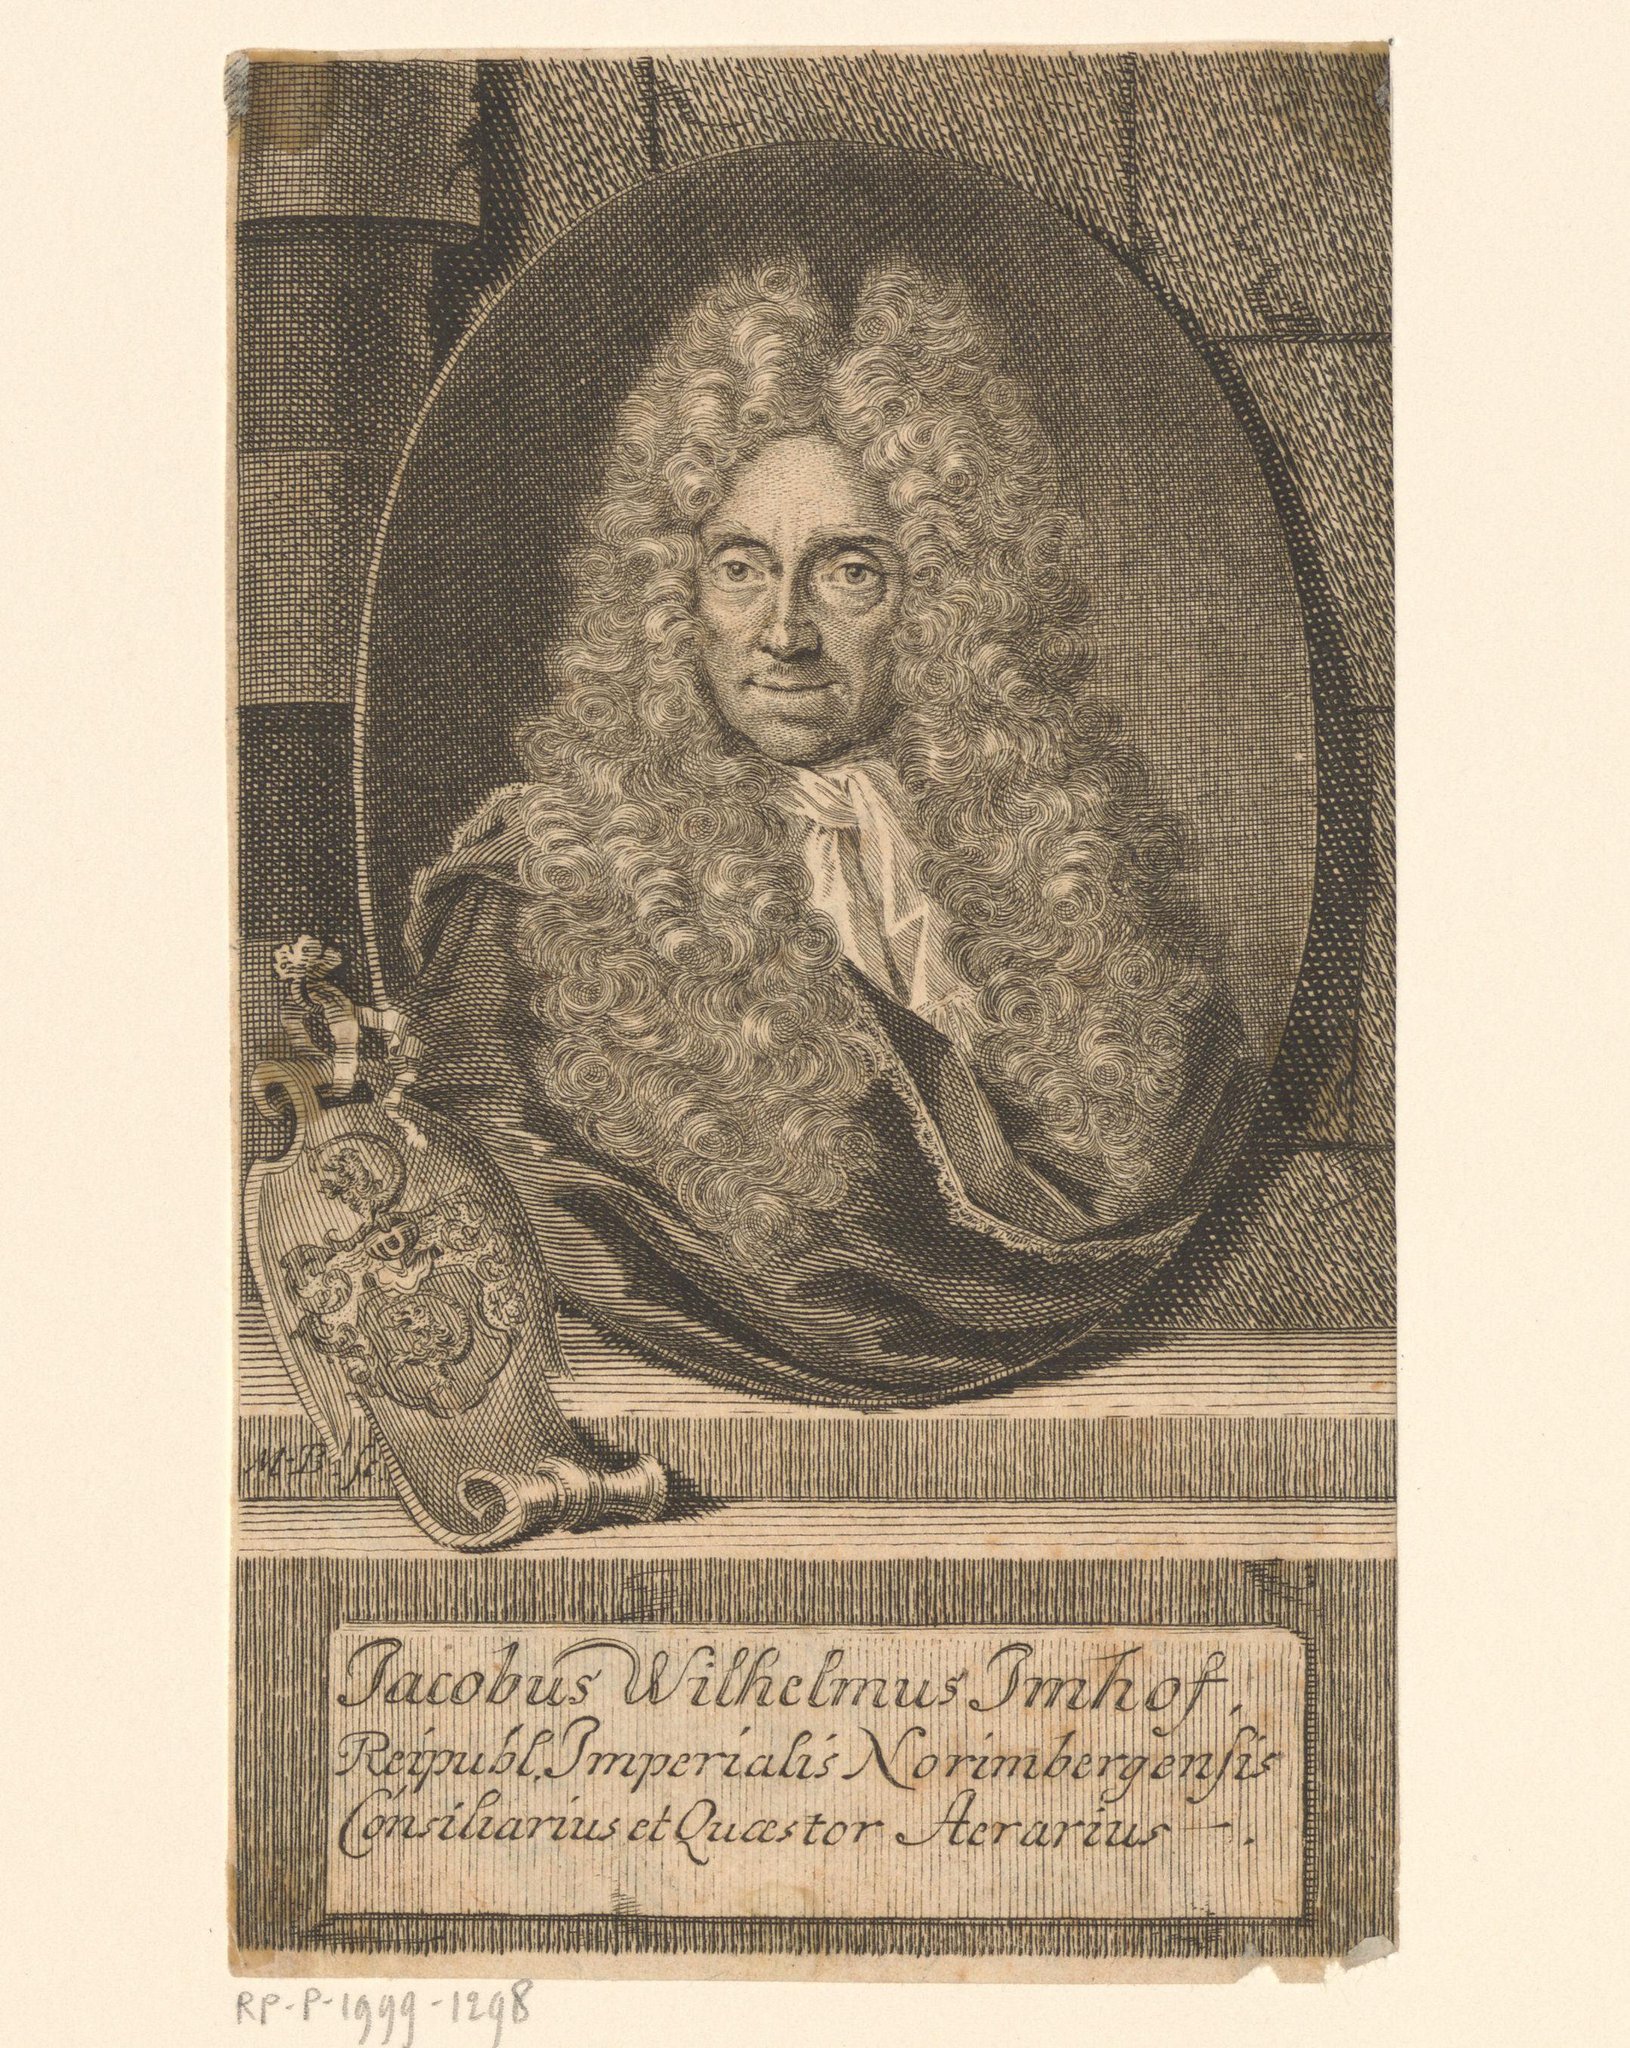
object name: print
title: Portret van Jacob Wilhelm Imhof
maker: martin bernigeroth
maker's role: print maker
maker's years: 1670-1733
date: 1712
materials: paper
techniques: engraving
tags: historical persons, lawyer, attorney at law, armorial bearing, heraldry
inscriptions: collector's mark: Lugt 2760, collector's mark: Lugt 2228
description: Prent uit: Deutsche Acta Eruditorum (...). Leipzig: Johann Gottlieb Gleditsch en zoon, 1712, dl. 6.